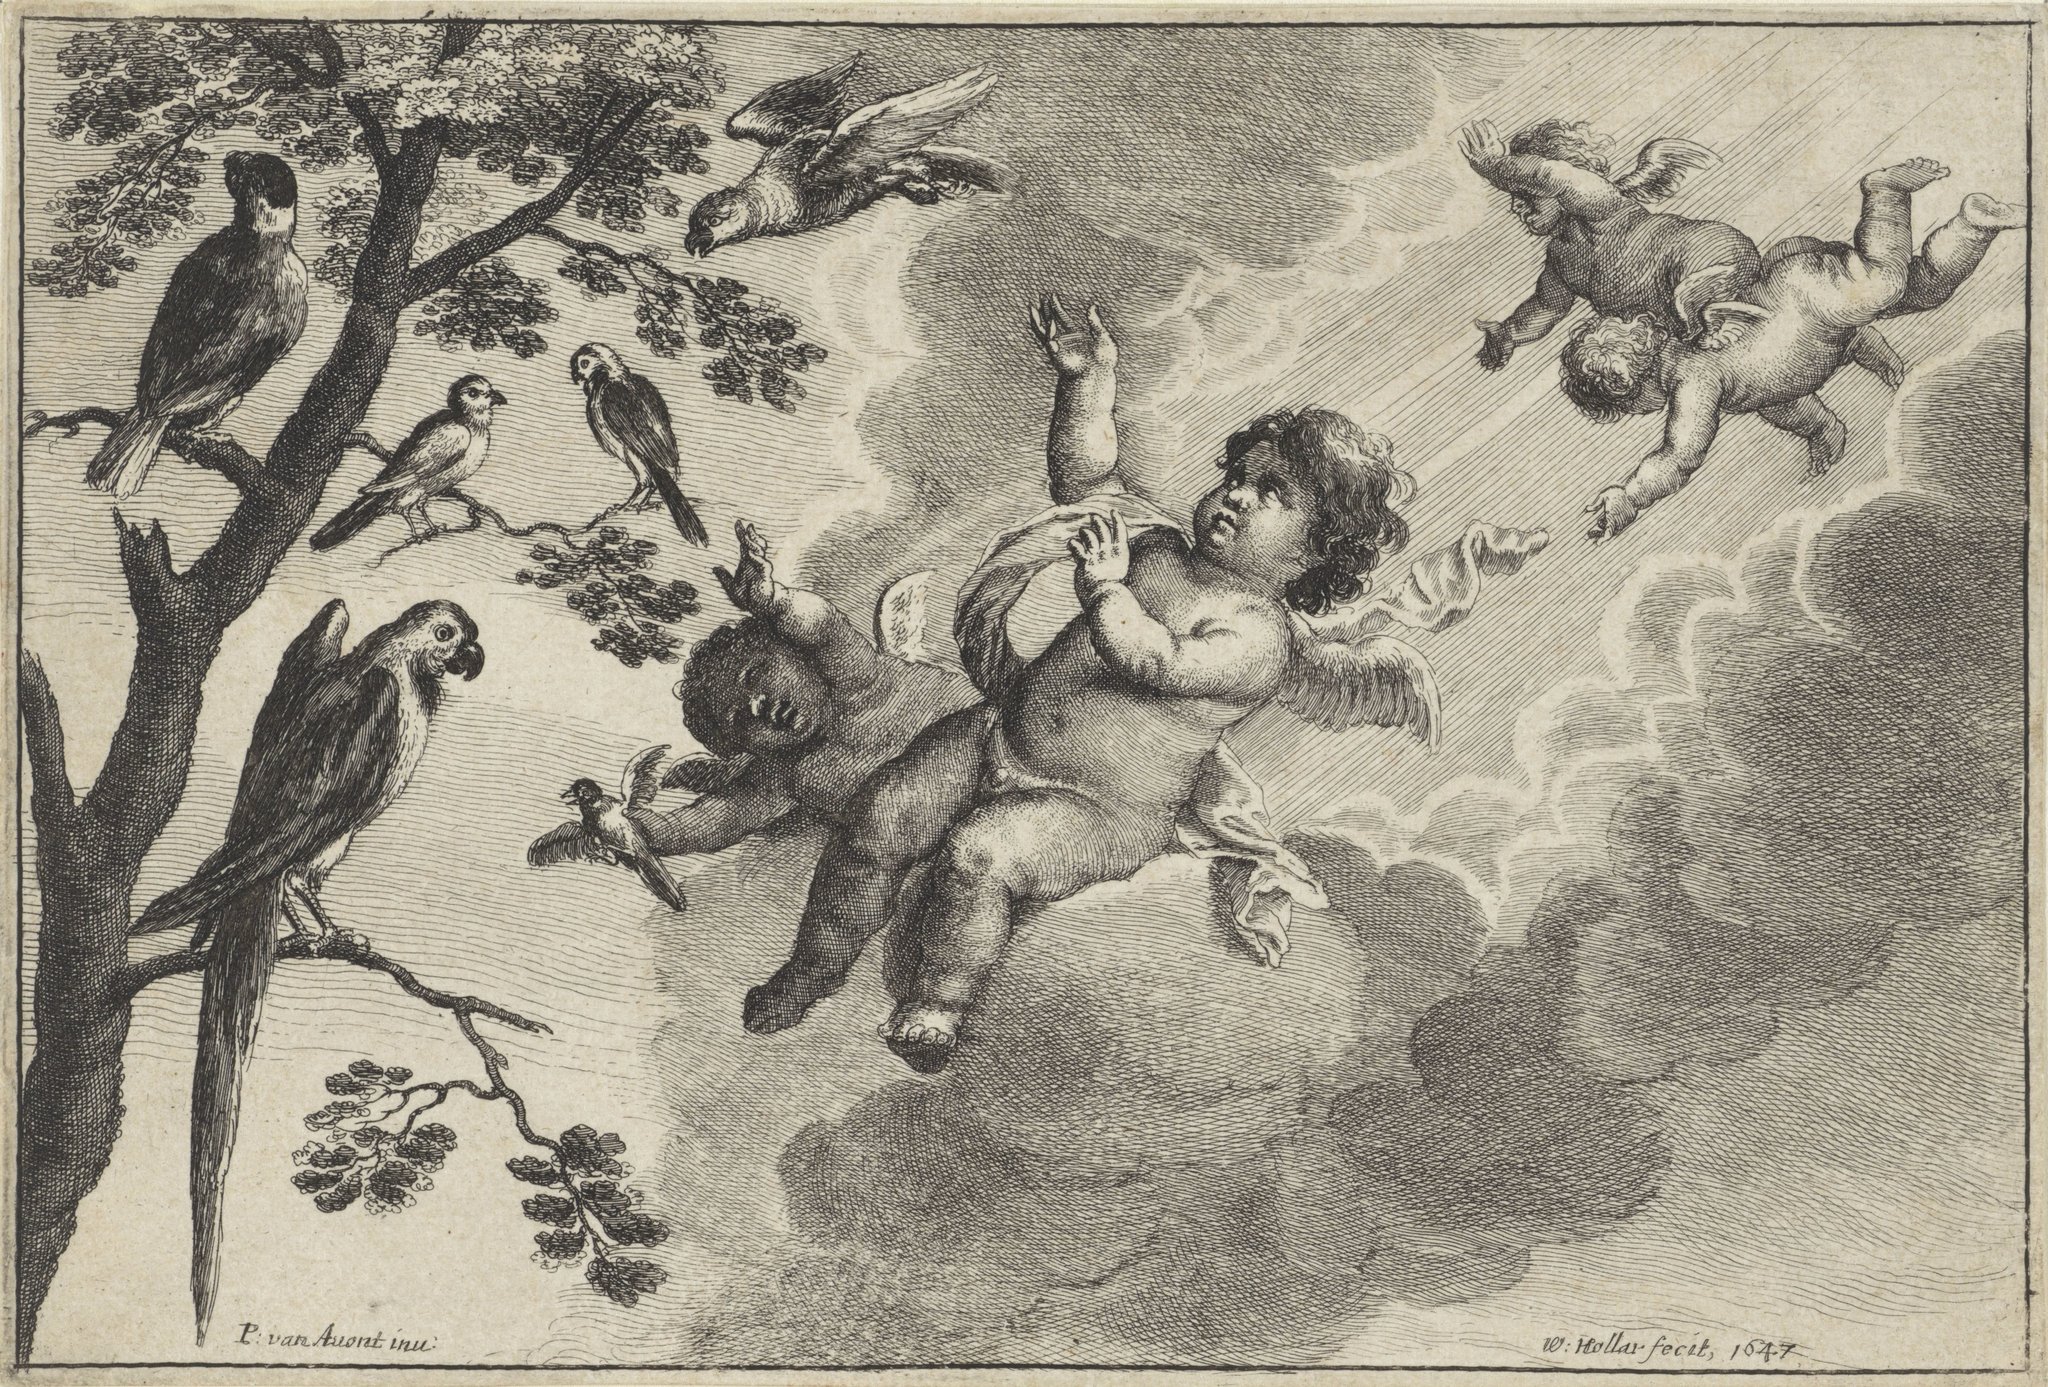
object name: print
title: De vier elementen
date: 1647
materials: paper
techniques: etching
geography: antwerp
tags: air (one of the four elements), birds, cupids: 'amores', 'amoretti', 'putti'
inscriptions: collector's mark: Lugt 240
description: Het vierde element Water ontbreekt vooralsnog in deze serie.